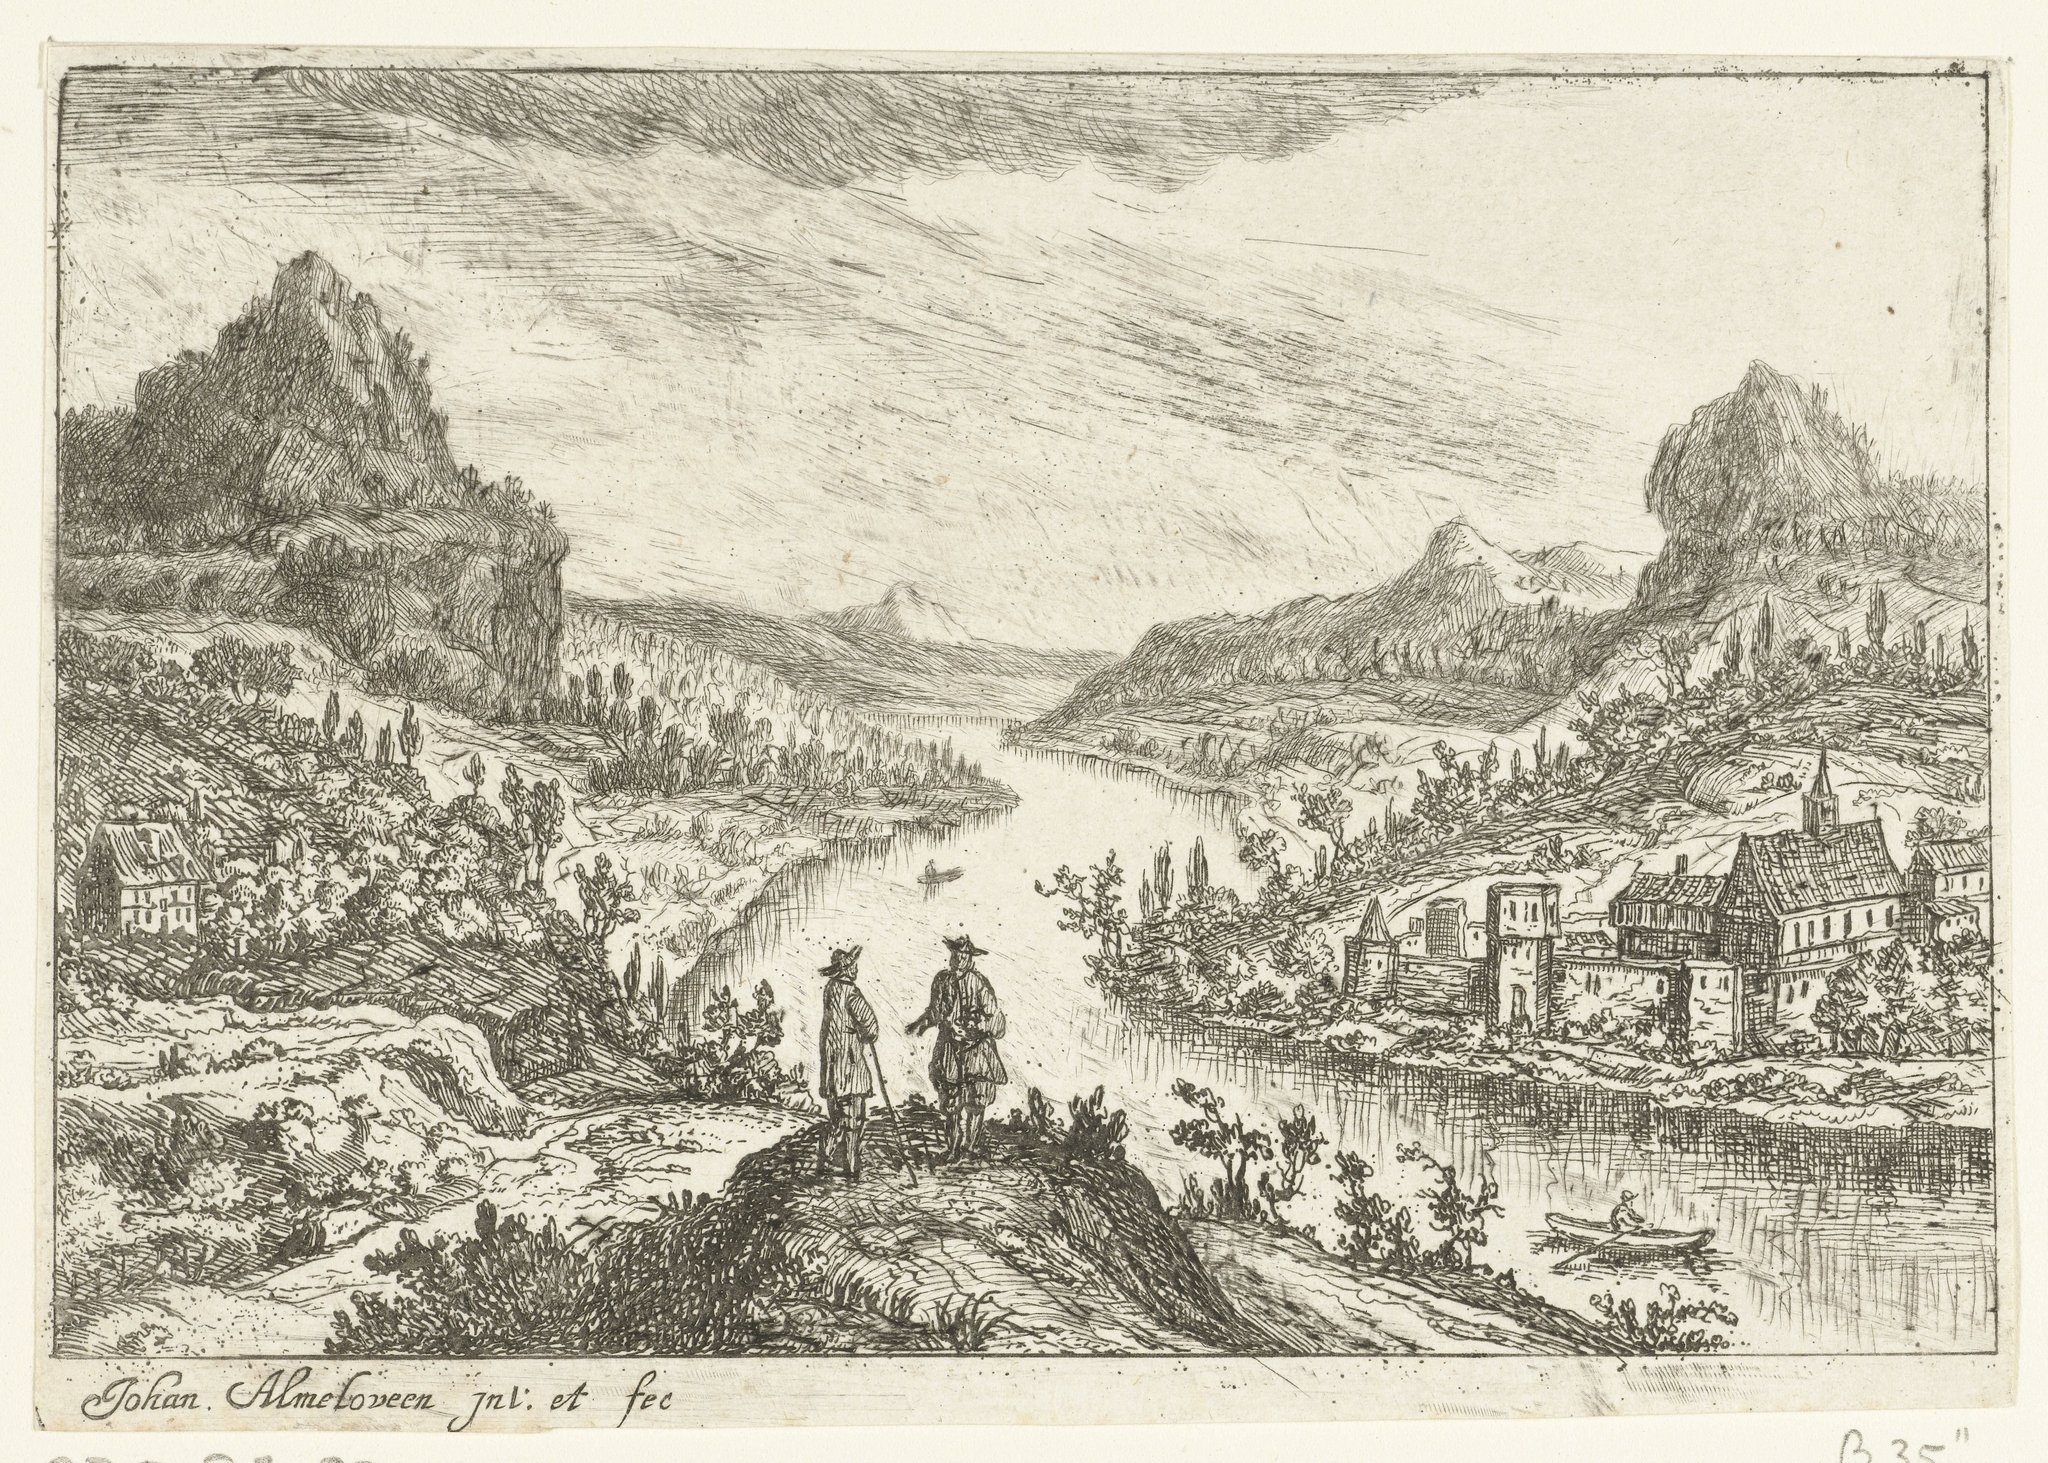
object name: print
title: Rivierlandschap met twee mannen op een heuvel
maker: jan van almeloveen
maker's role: draughtsman, print maker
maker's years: 1652-1683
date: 1662-1683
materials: paper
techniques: etching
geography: netherlands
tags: river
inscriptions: collector's mark: Lugt 240